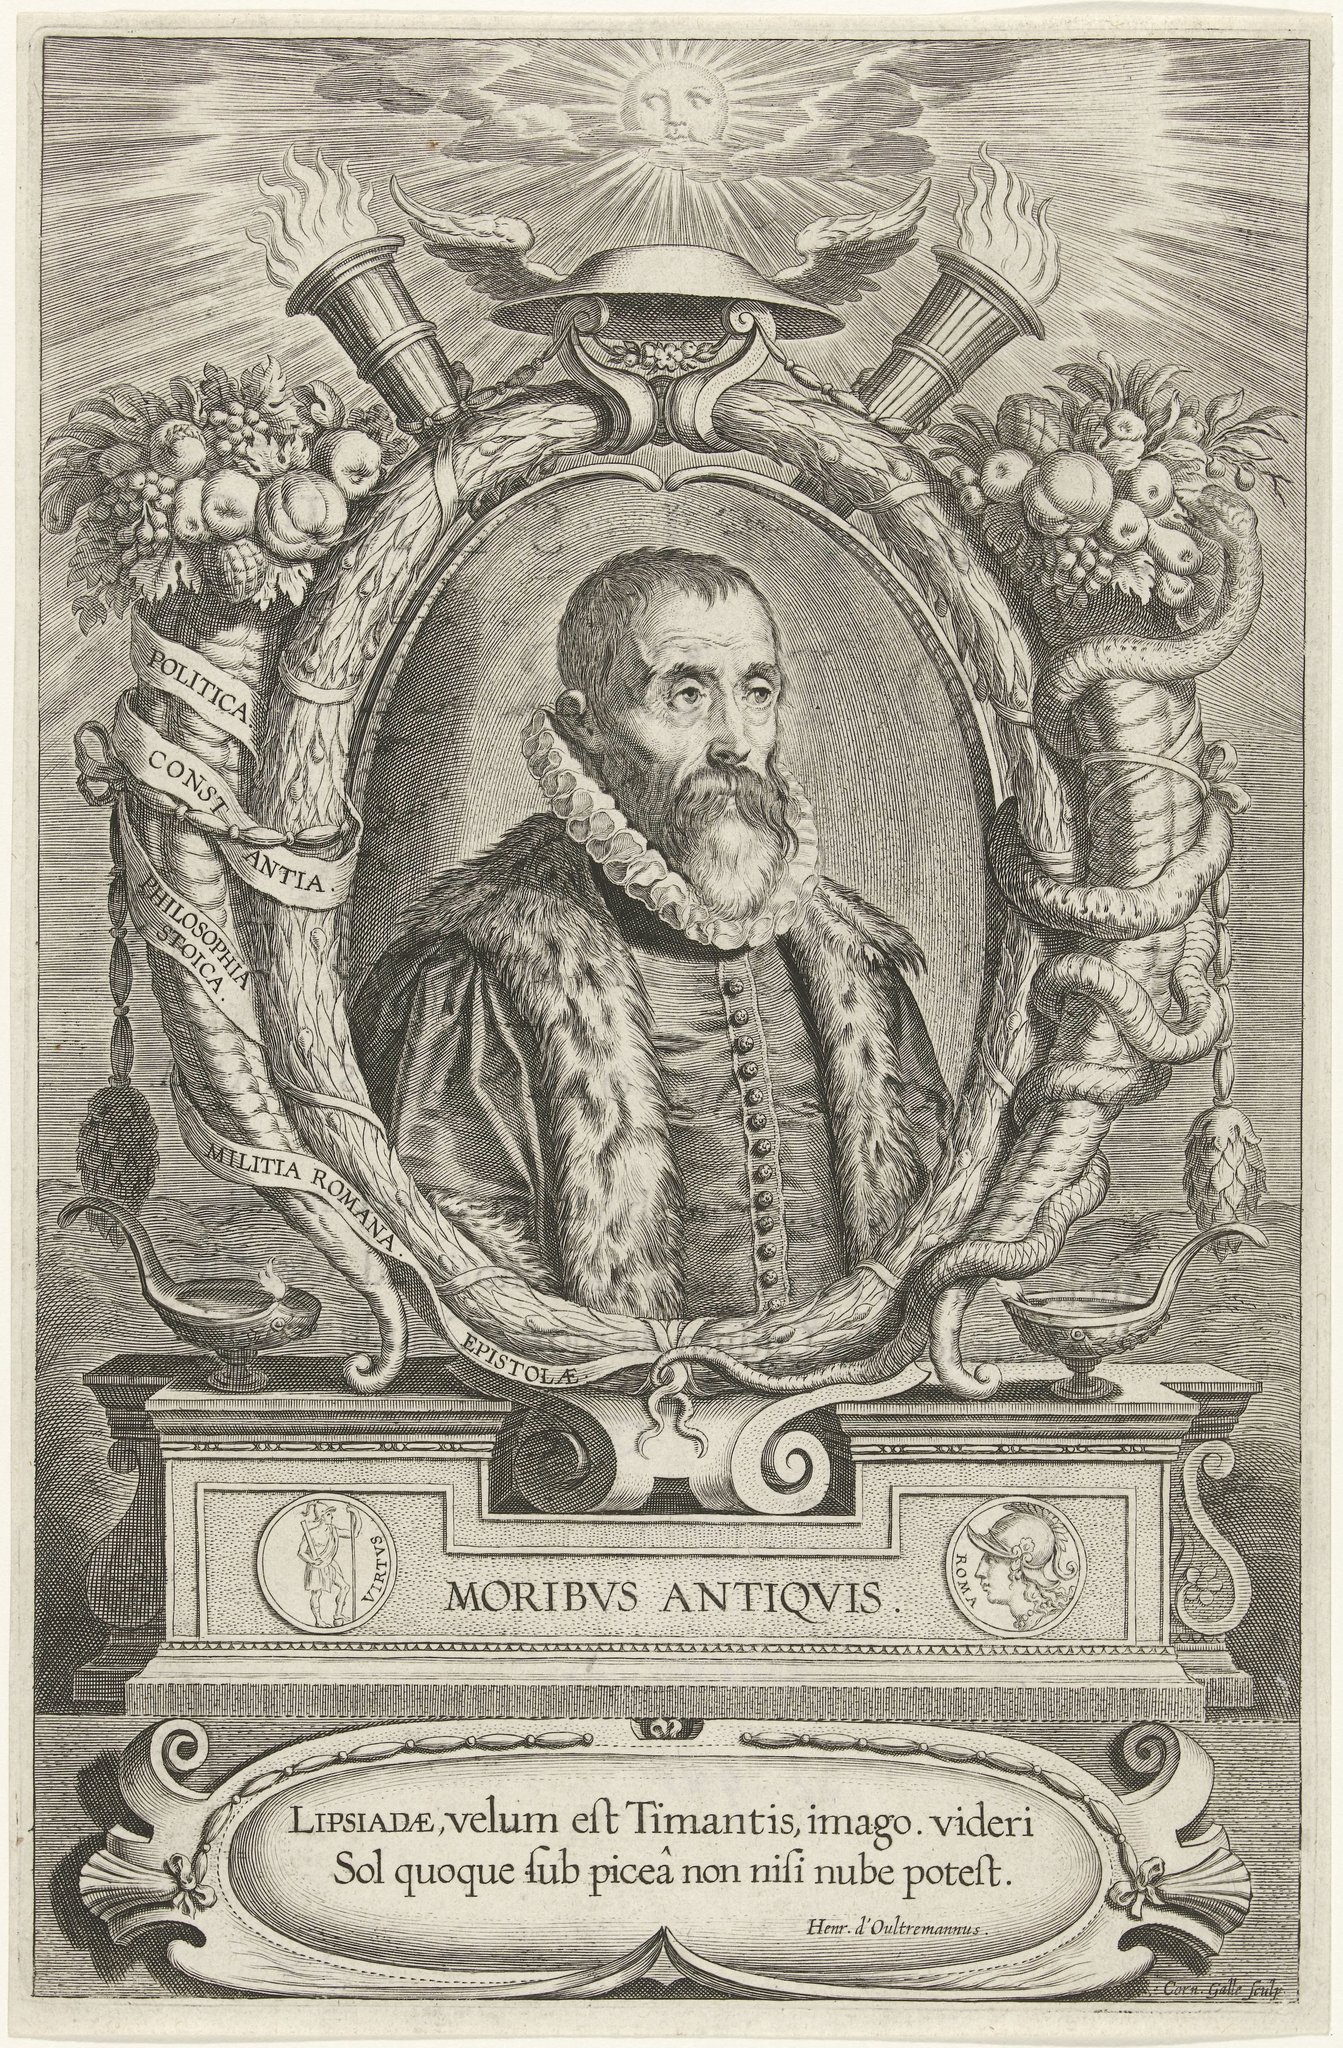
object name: print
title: Portret van Justus Lipsius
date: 1615-1652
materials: paper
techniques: engraving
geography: southern netherlands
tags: louvain, justus lipsius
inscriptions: collector's mark: Lugt 2228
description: Portret van de auteur Justus Lipsius, in een ovale omlijsting met vruchten, slangen en fakkels. Aan weerszijden staan twee olielampjes op een sokkel met het opschrift: Moribus antiquis. Onder de voorstelling een cartouche met een Latijns vers van Oultreman.